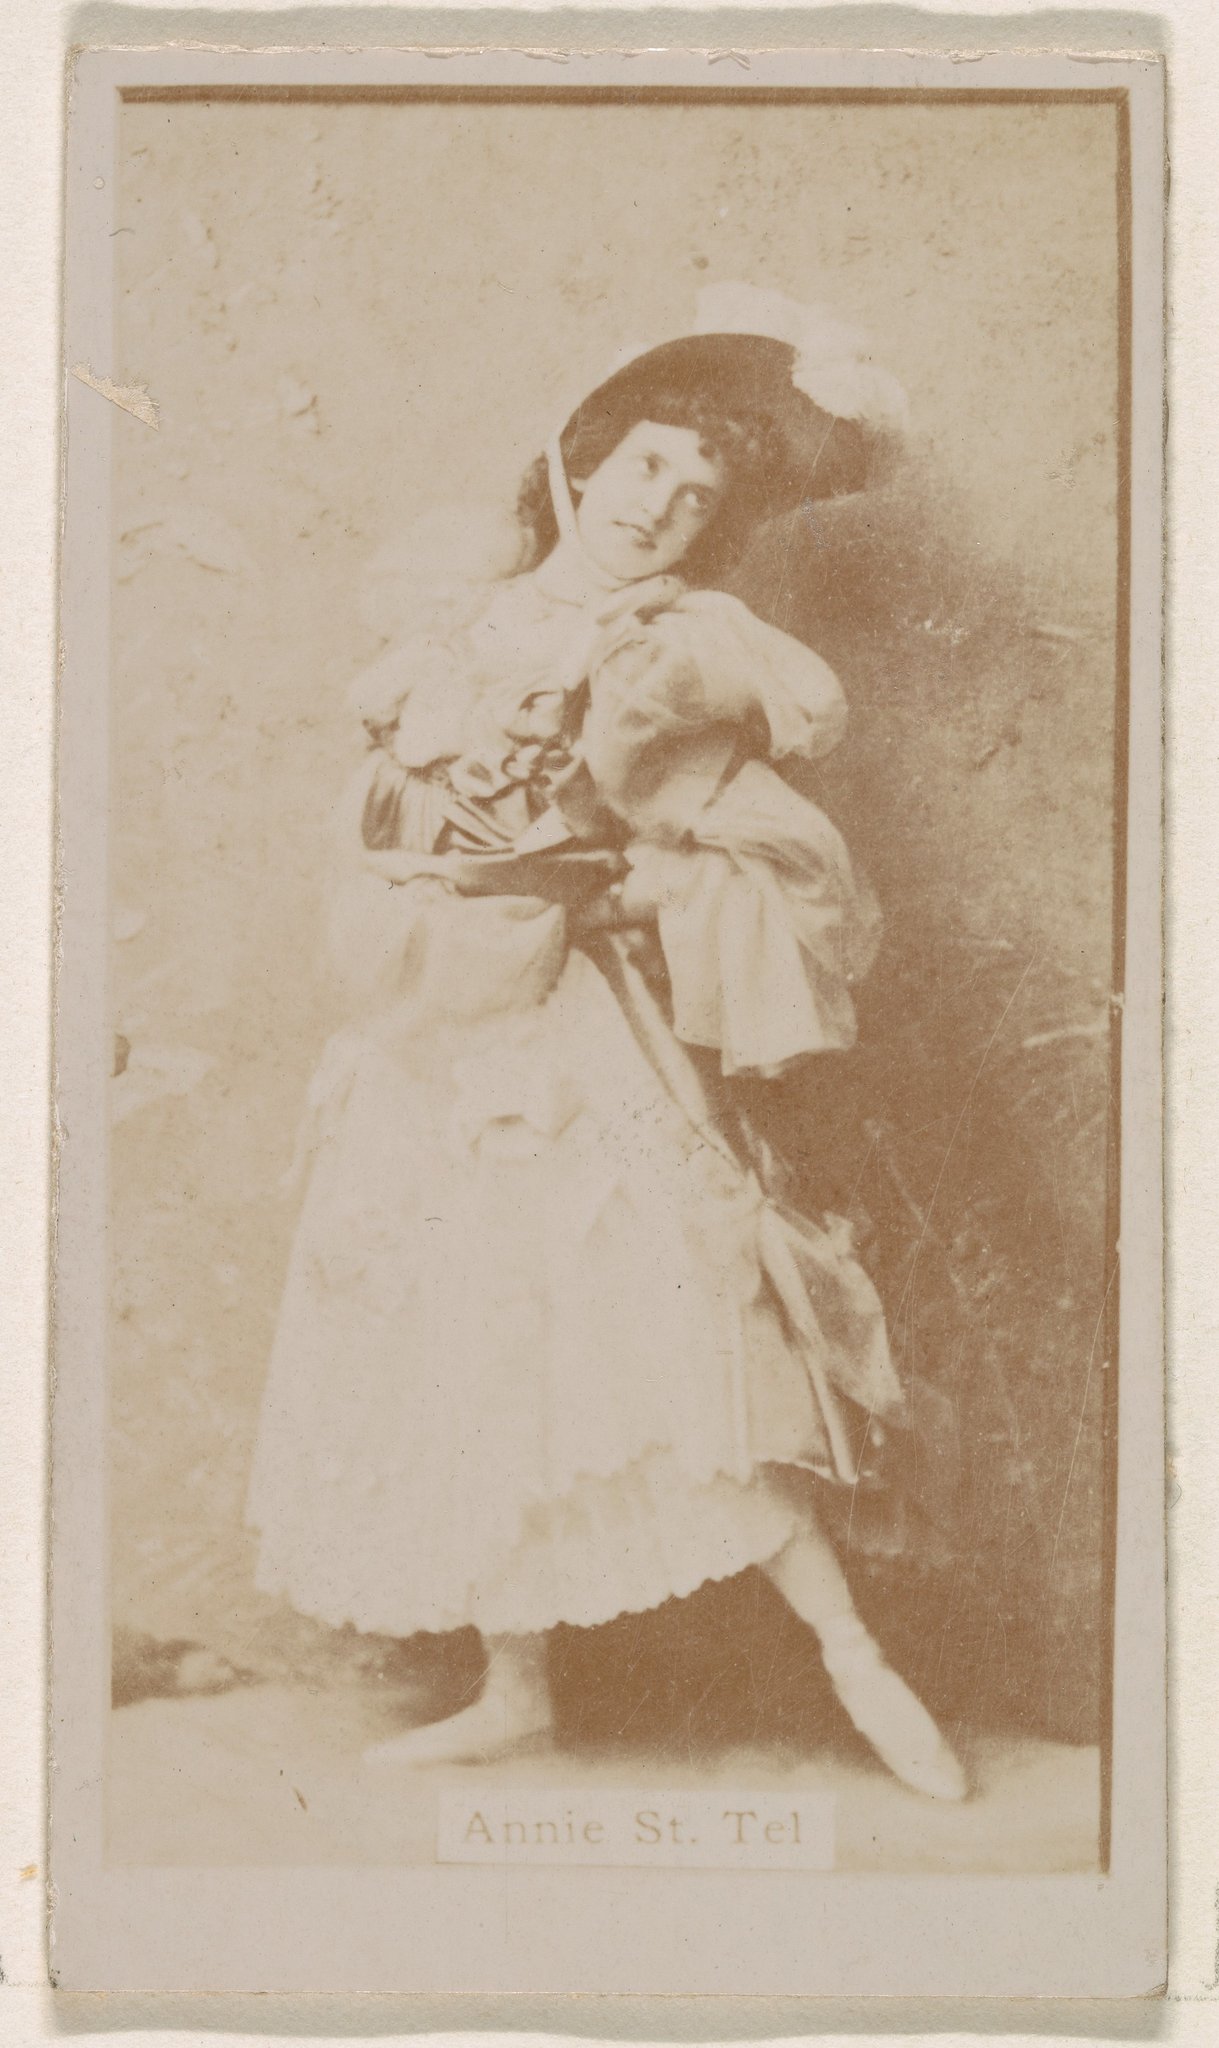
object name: photograph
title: Annie St. Tel, from the Actresses series (N245) issued by Kinney Brothers to promote Sweet Caporal Cigarettes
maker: kinney brothers tobacco company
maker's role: publisher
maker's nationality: american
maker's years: 1869-2011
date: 1890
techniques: albumen silver print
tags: portraits,women,actresses